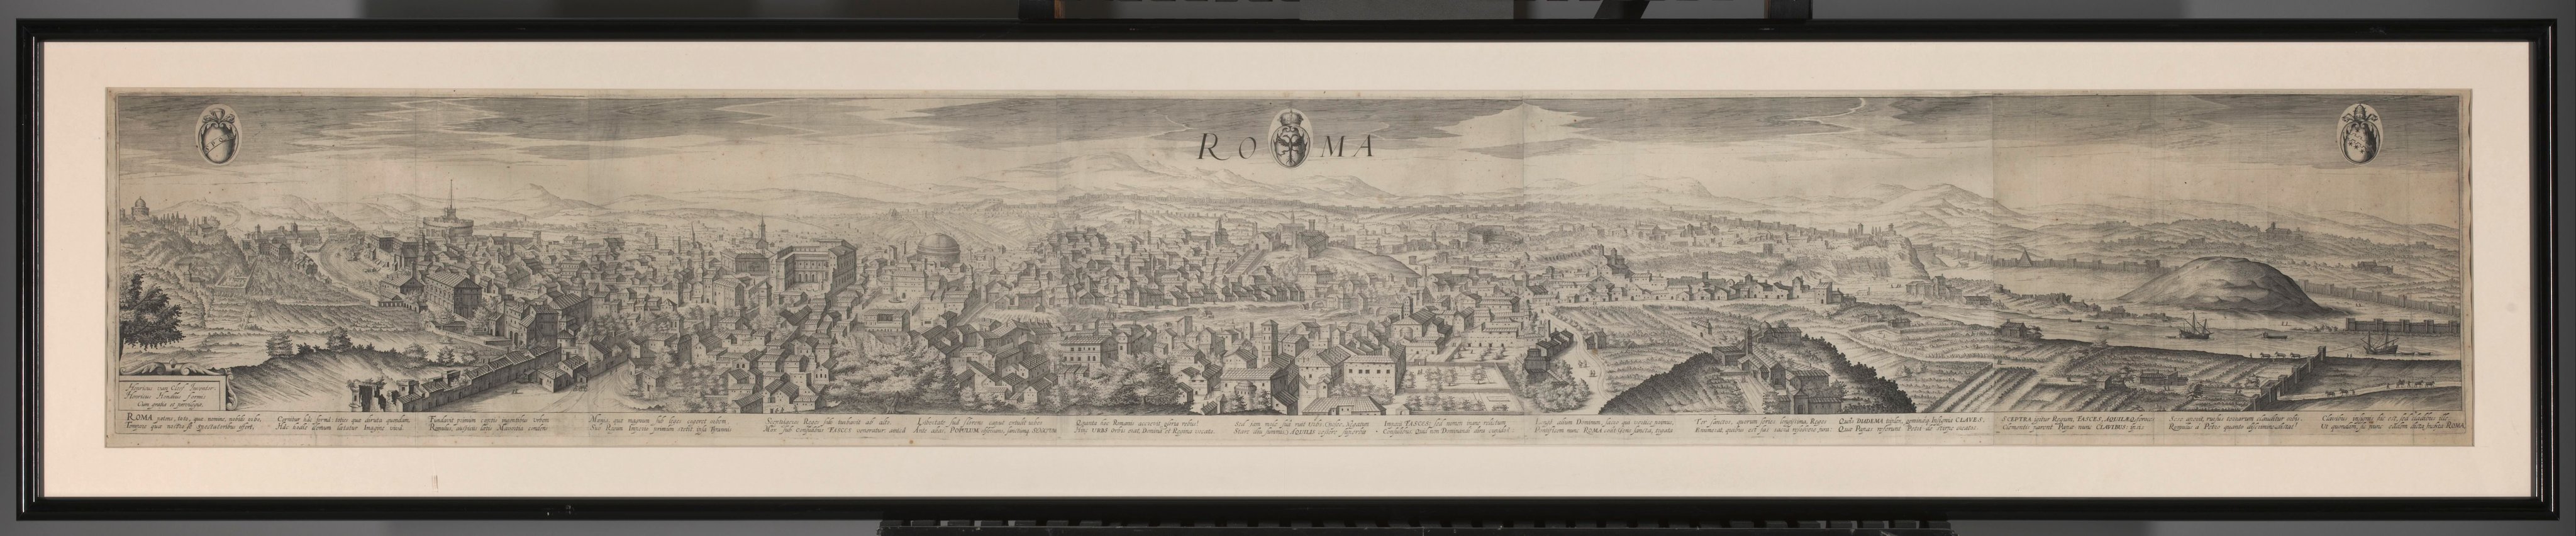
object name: print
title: Roma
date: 1590-1610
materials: paper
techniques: engraving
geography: netherlands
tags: rome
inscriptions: inscription: ‘Roma potens [...] Senatum’, signature: ‘Henricus van Cleef inventor / Henricus Hondius formis Cum gratia et privilegio’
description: Gezicht op Rome vanaf de Janiculum. Onderaan een Latijns lofdicht over Rome.